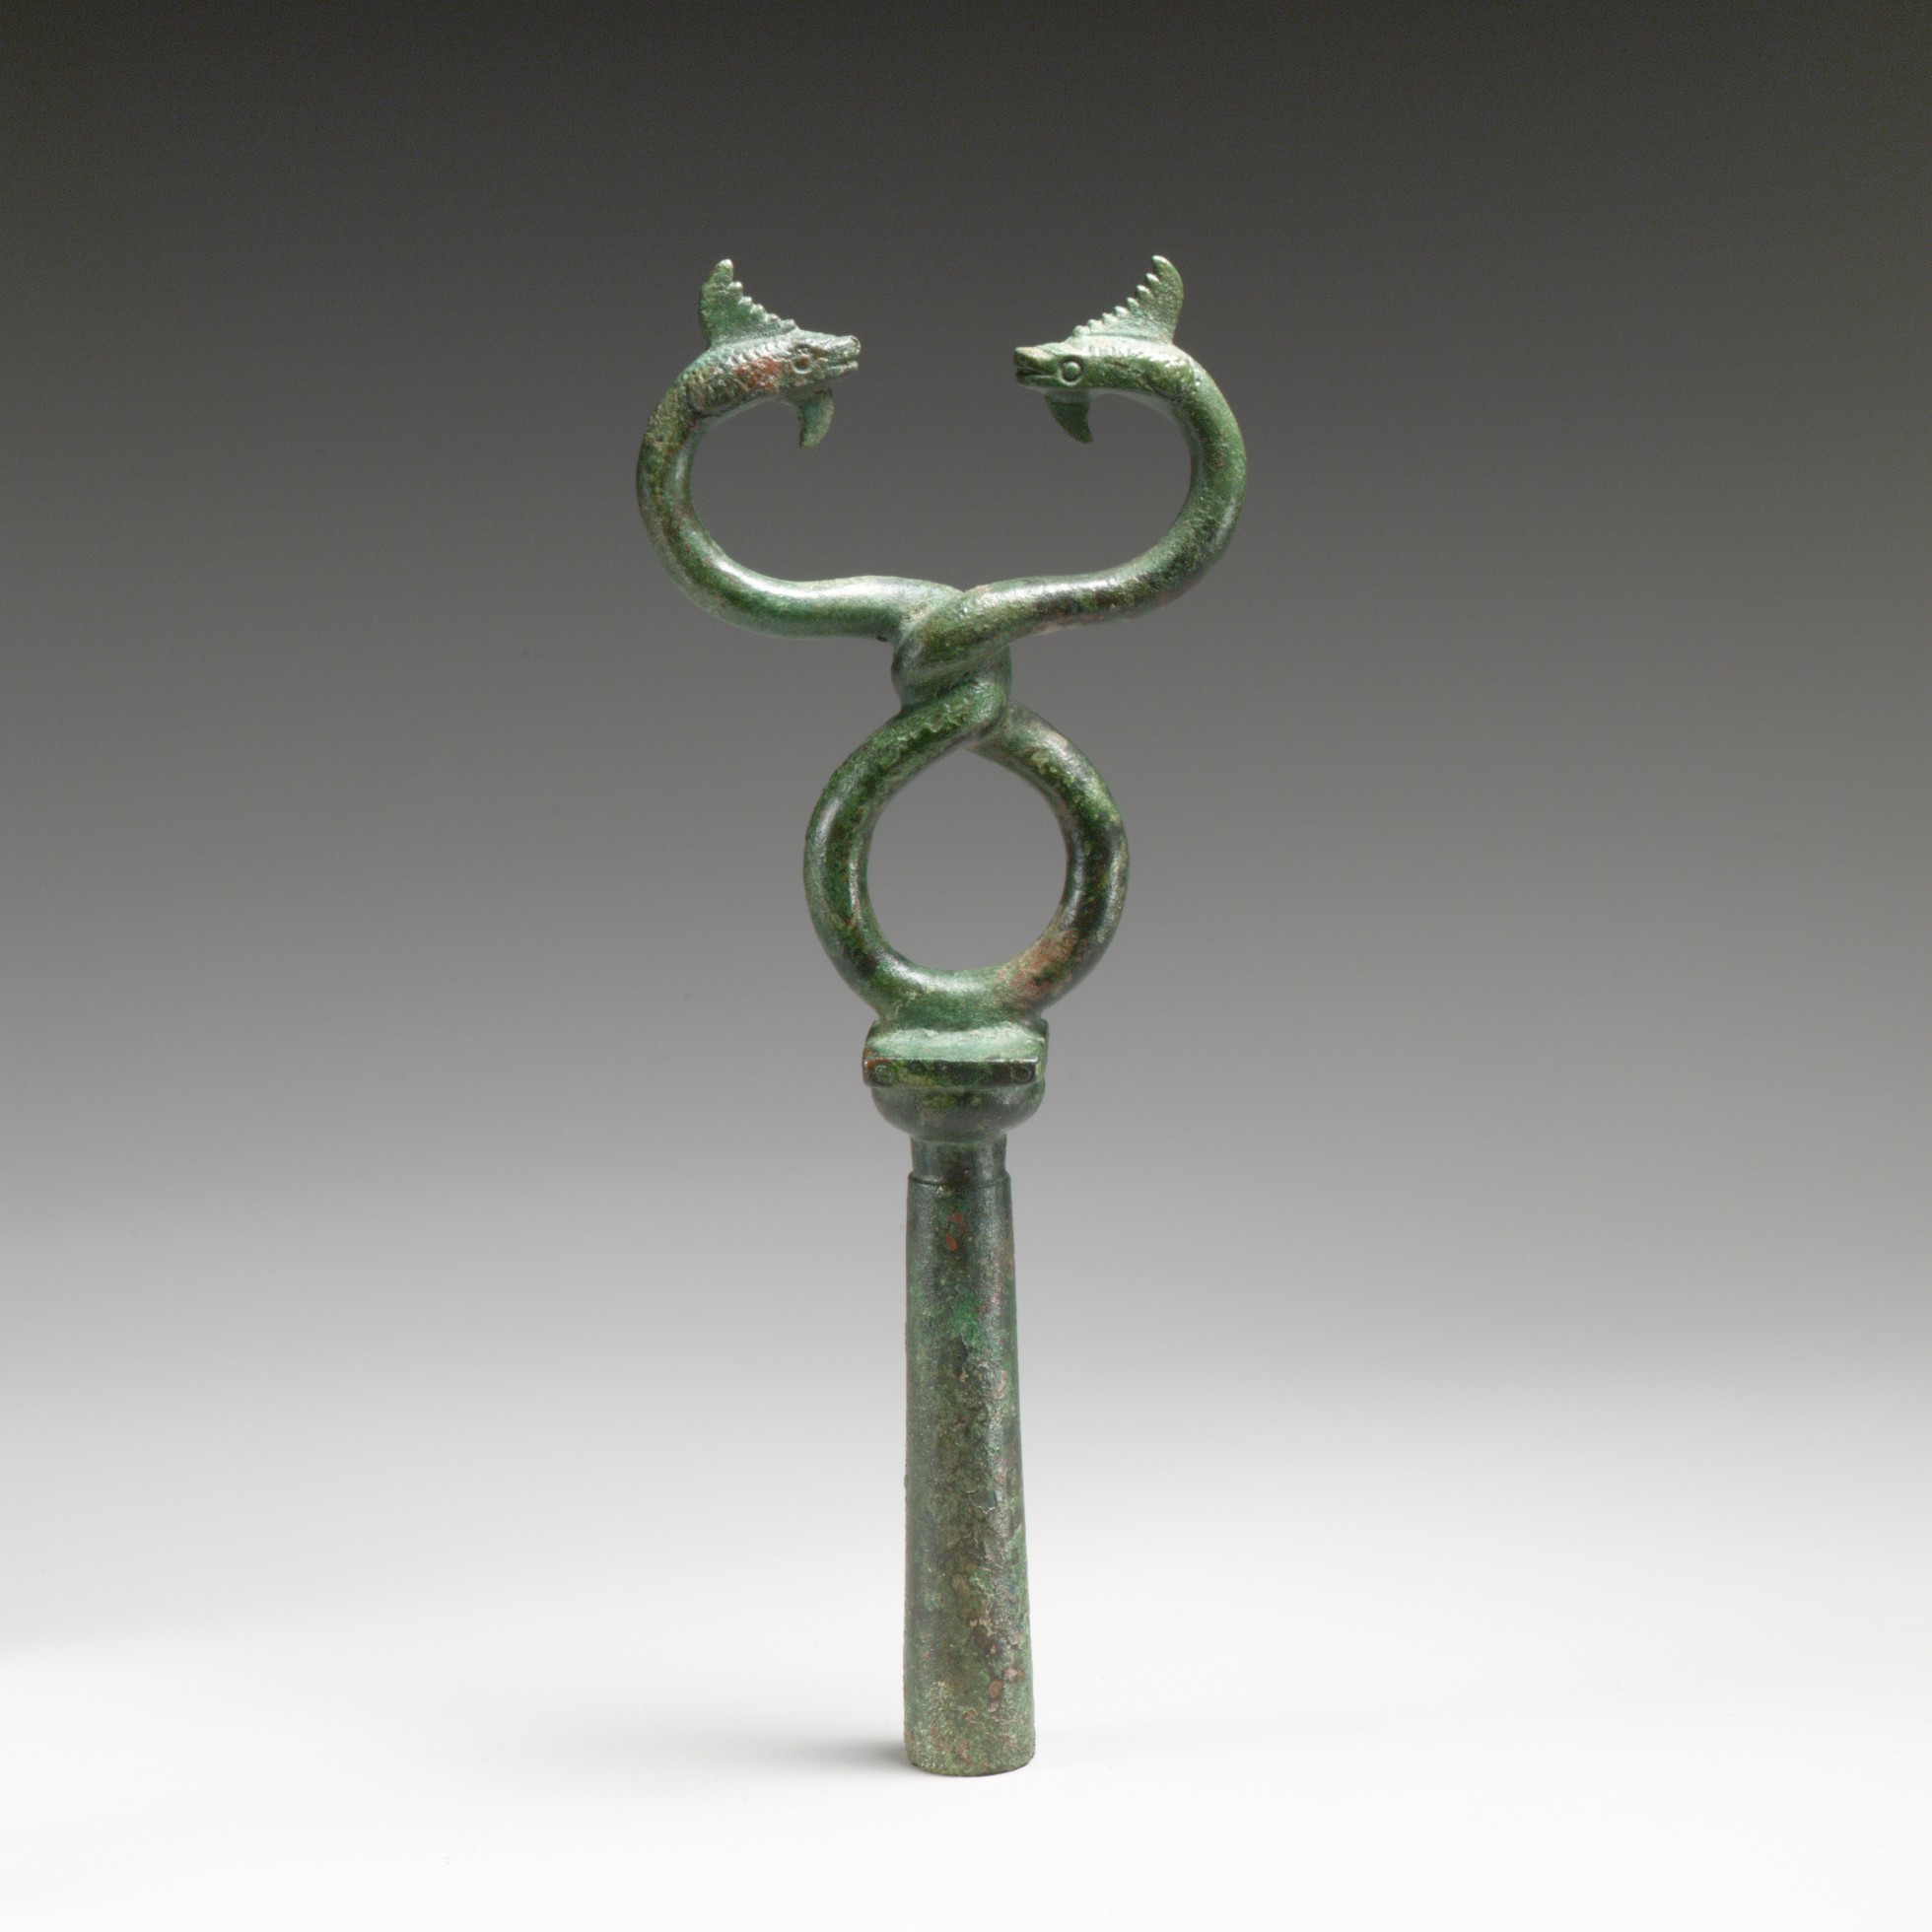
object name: finial of a kerykeion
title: Bronze finial of a kerykeion (herald's staff)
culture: greek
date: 534-468 BCE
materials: bronze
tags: snakes